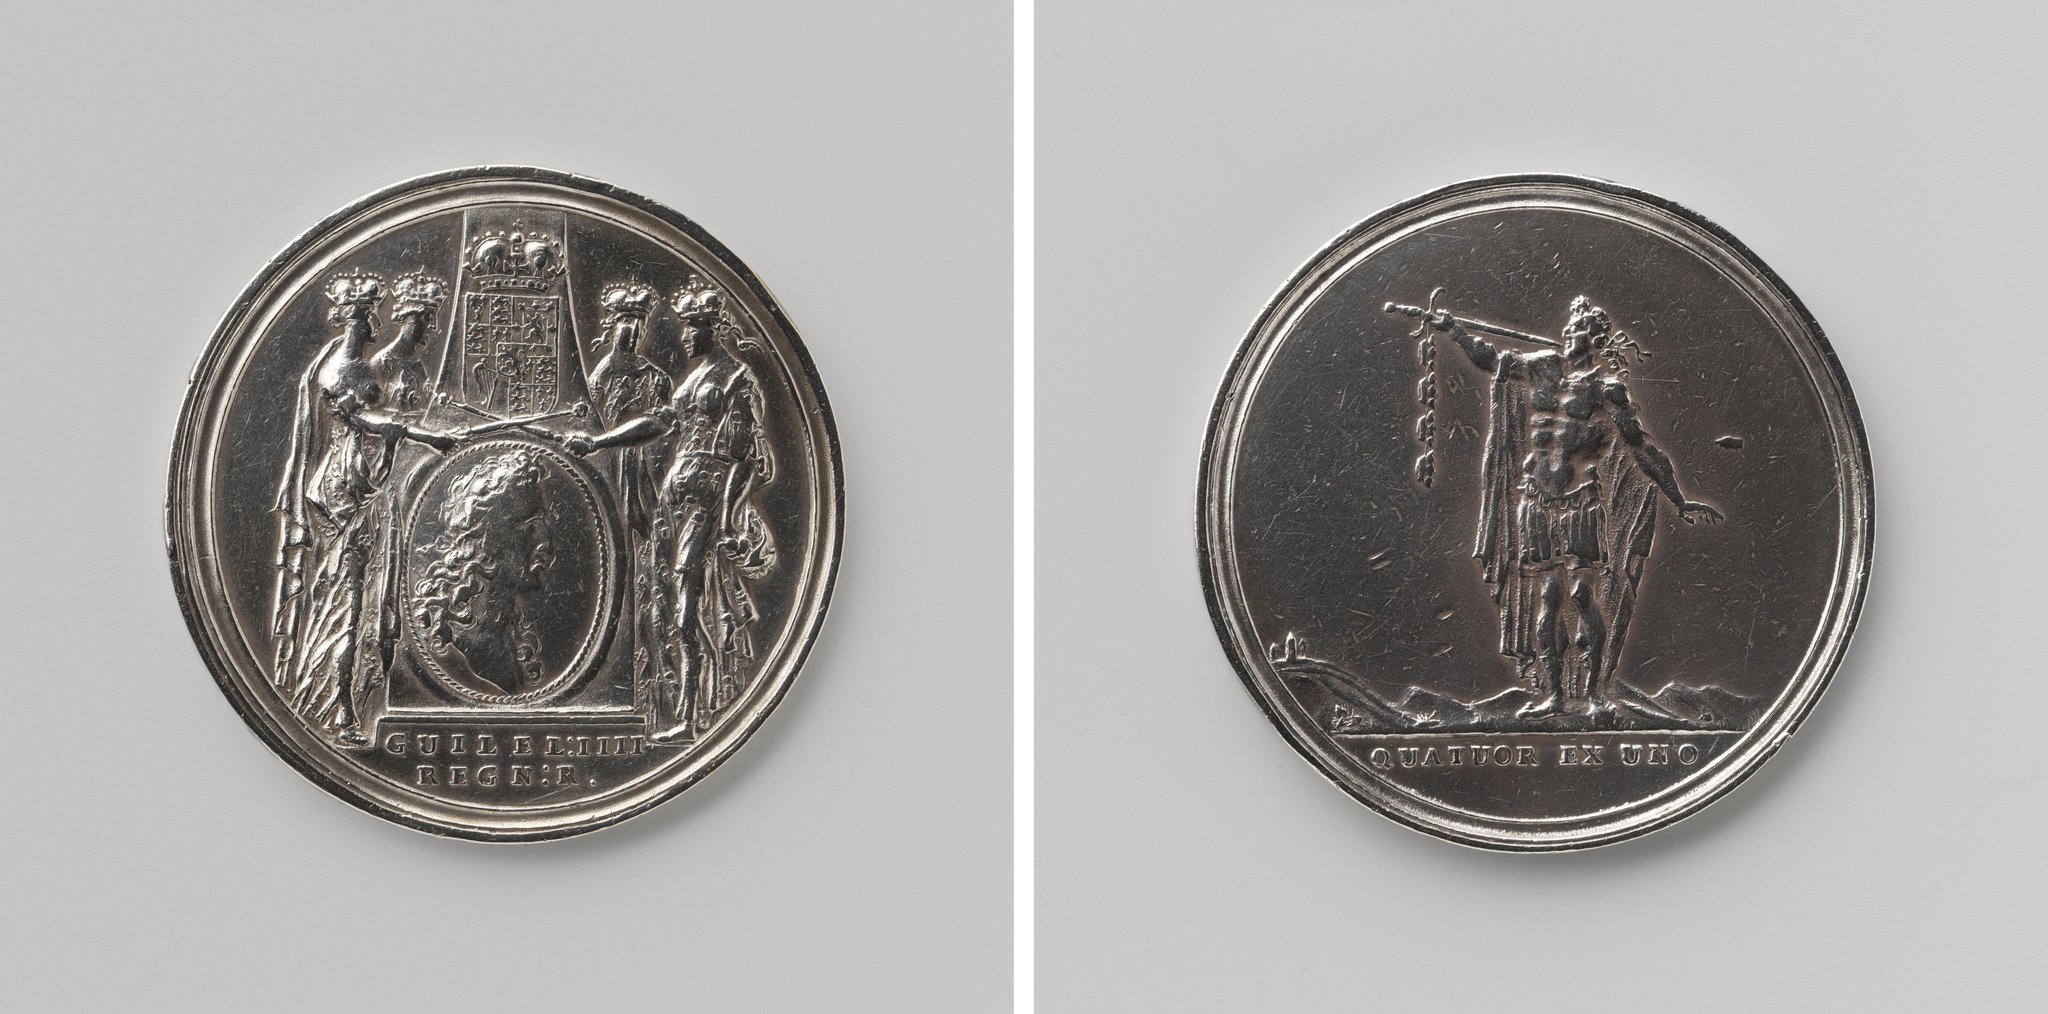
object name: history medal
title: Overwinning van Willem III op Jacobus II aan de Boyne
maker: jan luder (i)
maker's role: medailleur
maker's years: 1648-1719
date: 1690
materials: silver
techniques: striking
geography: netherlands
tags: the hague, william iii (prince of orange and king of england, scotland, and ireland)